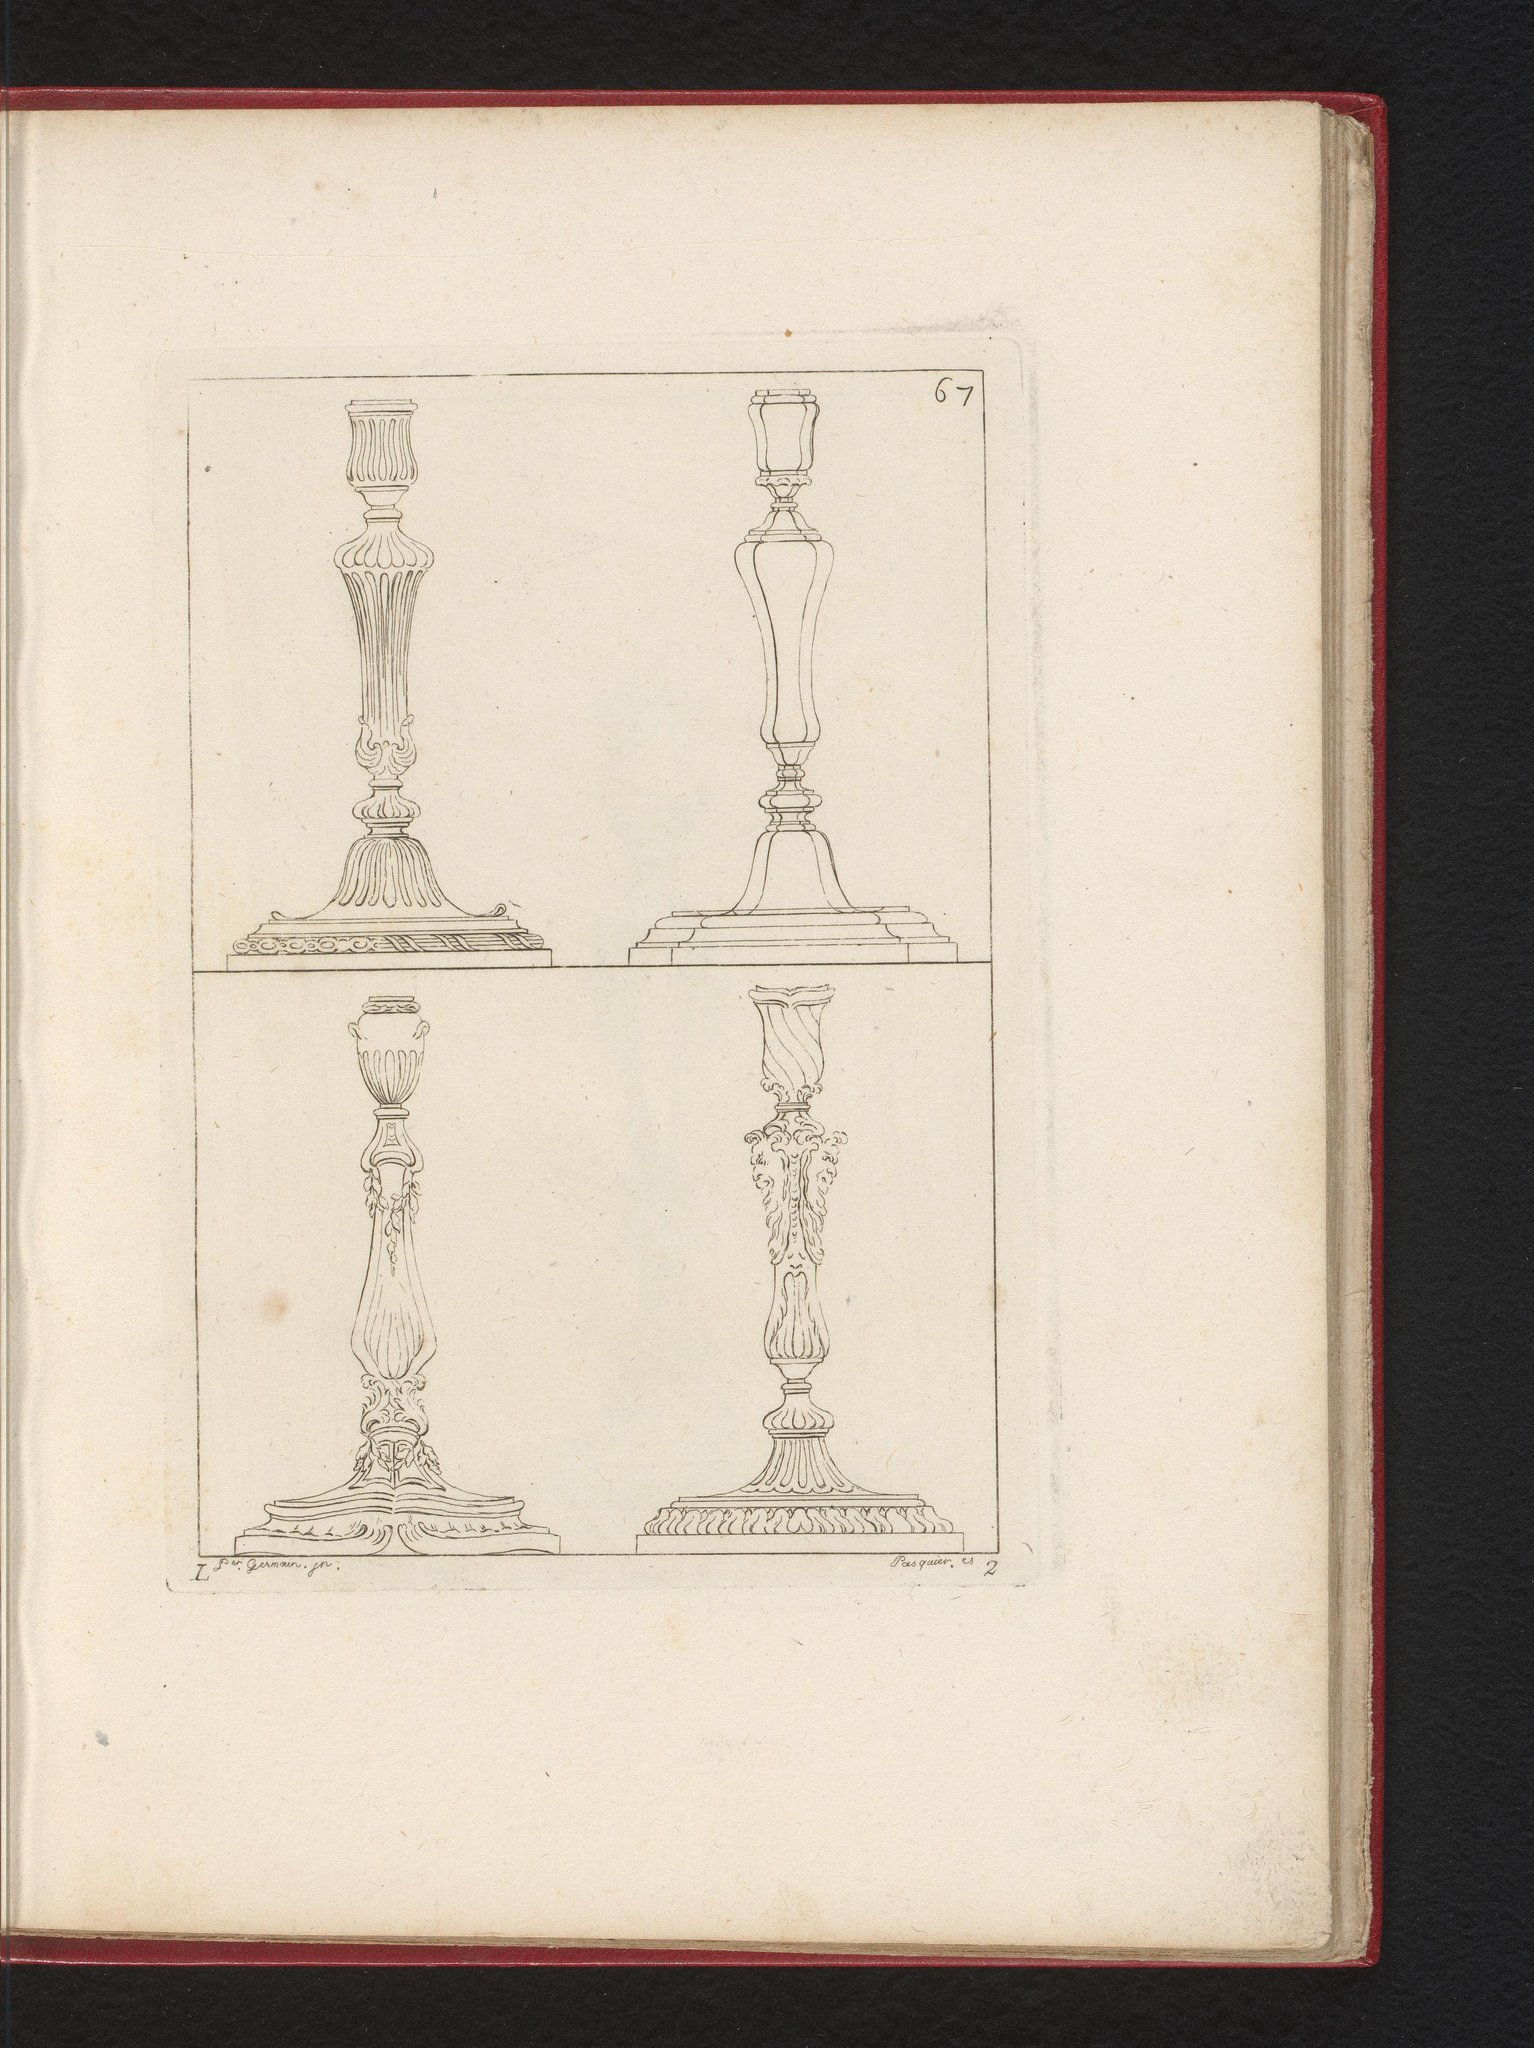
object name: album leaf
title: Zilverwerk en edelsmeedkunst, tweede deel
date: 1748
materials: paper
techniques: etching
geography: paris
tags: candlestick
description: Een aantal van de objecten in deze reeks heeft een eigen ondertitel, die verwijst naar genummerde 'cahiers' (afleveringen) waarin de prenten werden uitgegeven. Het is onduidelijk welke objecten recies bij welke aflevering horen. Daarom is die ondertitel enkel verwerkt bij de prent waarop die voorkomt.